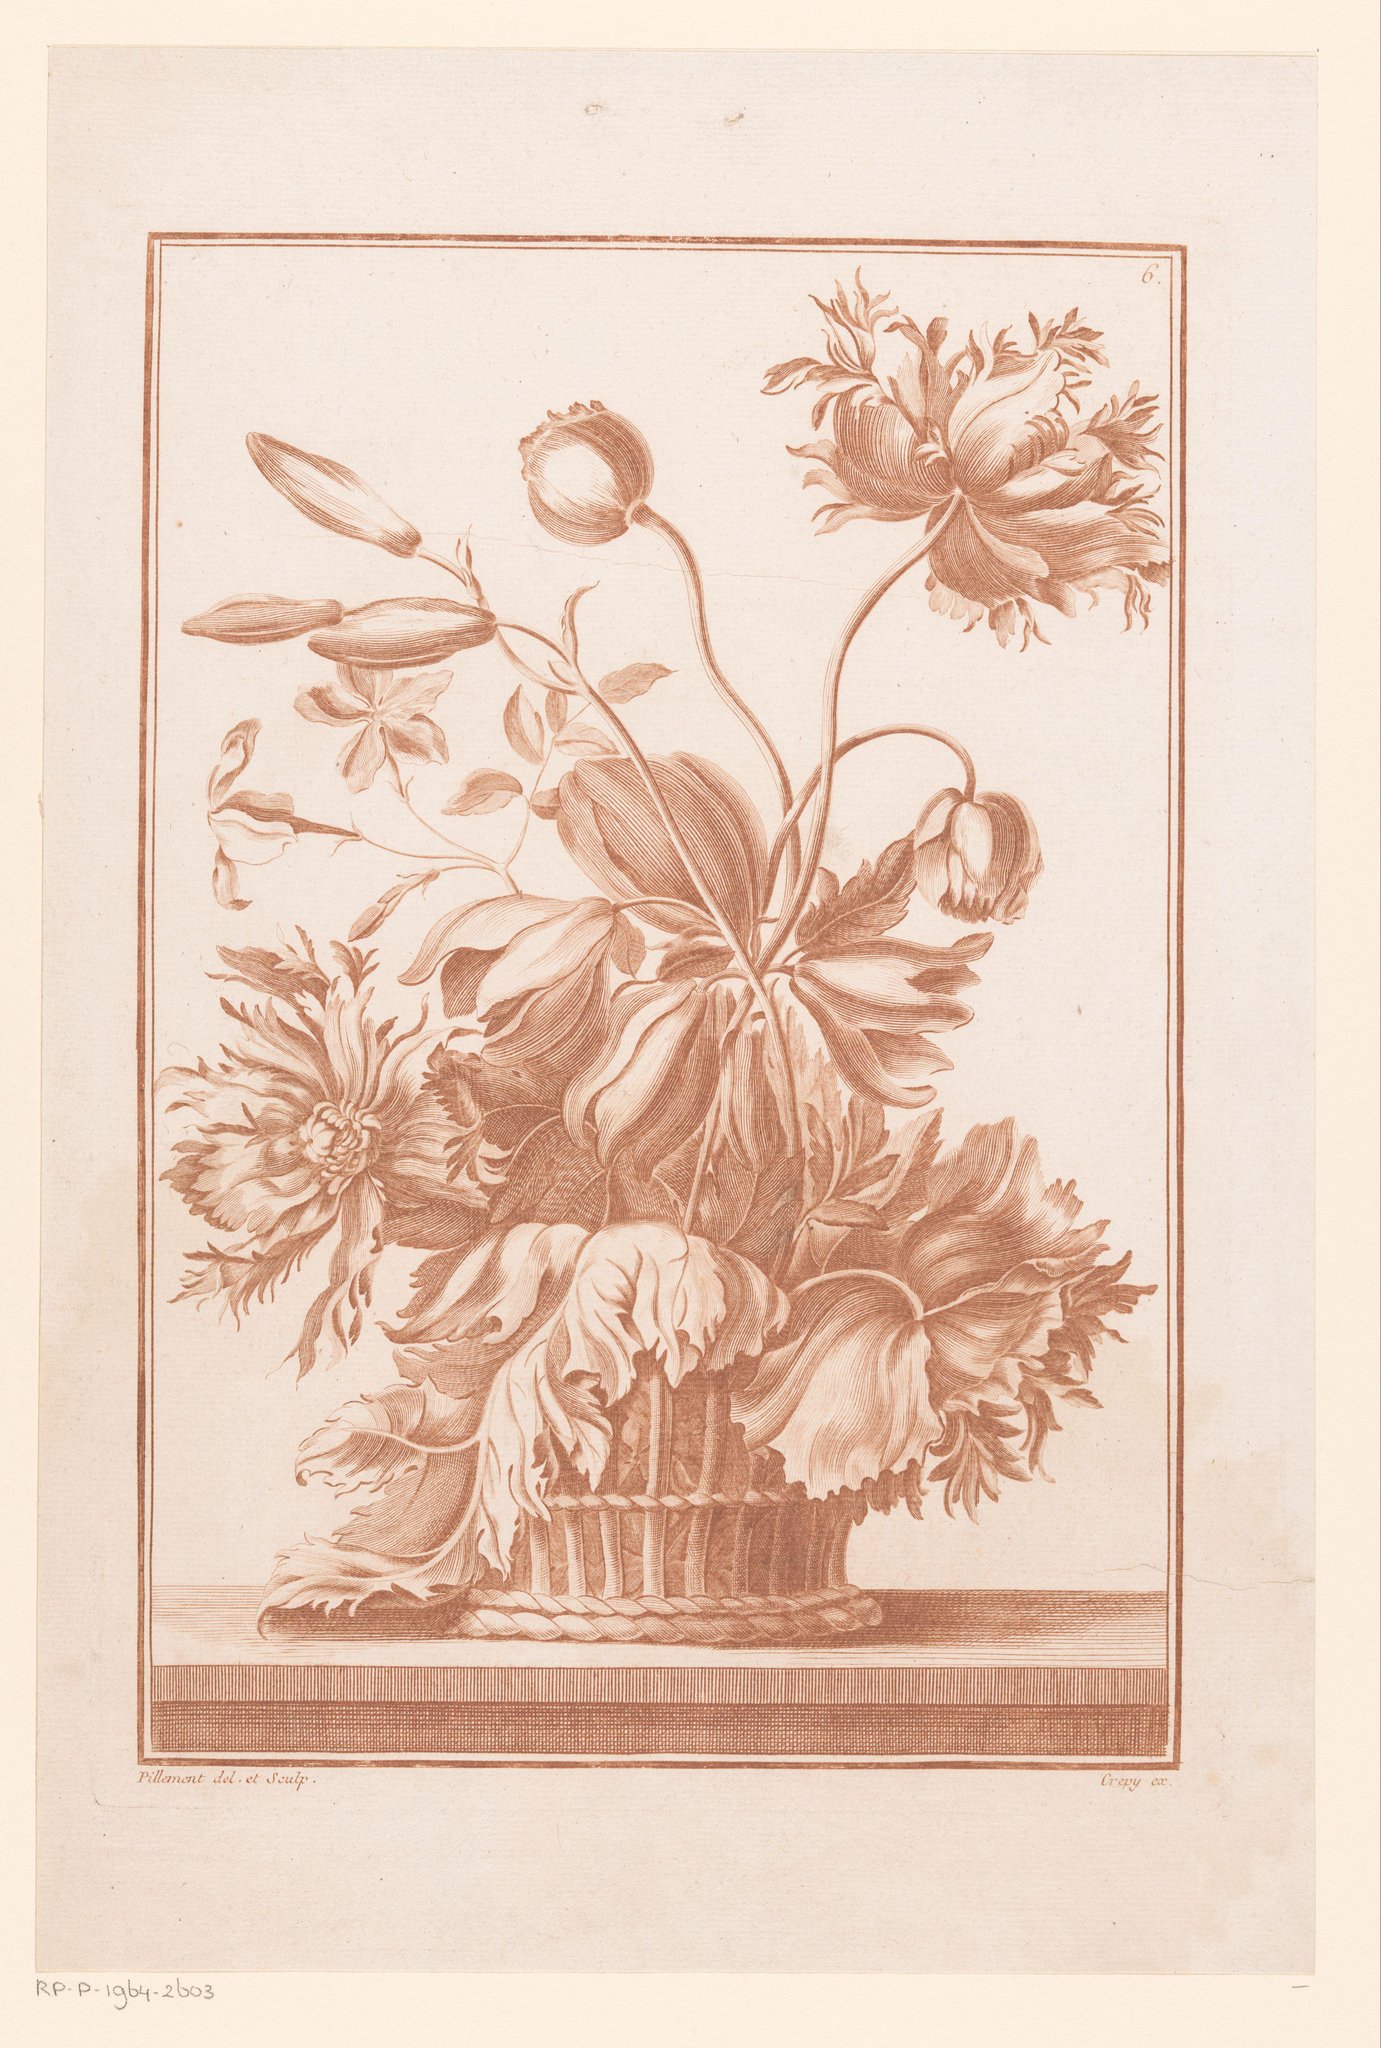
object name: print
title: Livre de Bouquets, Corbeille et Vases de Fleurs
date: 1753-1790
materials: paper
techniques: engraving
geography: paris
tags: cut flowers; nosegay, bunch of flowers, container made of plant material other than wood: basket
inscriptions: collector's mark: Lugt 2228, collector's mark: Lugt 2760